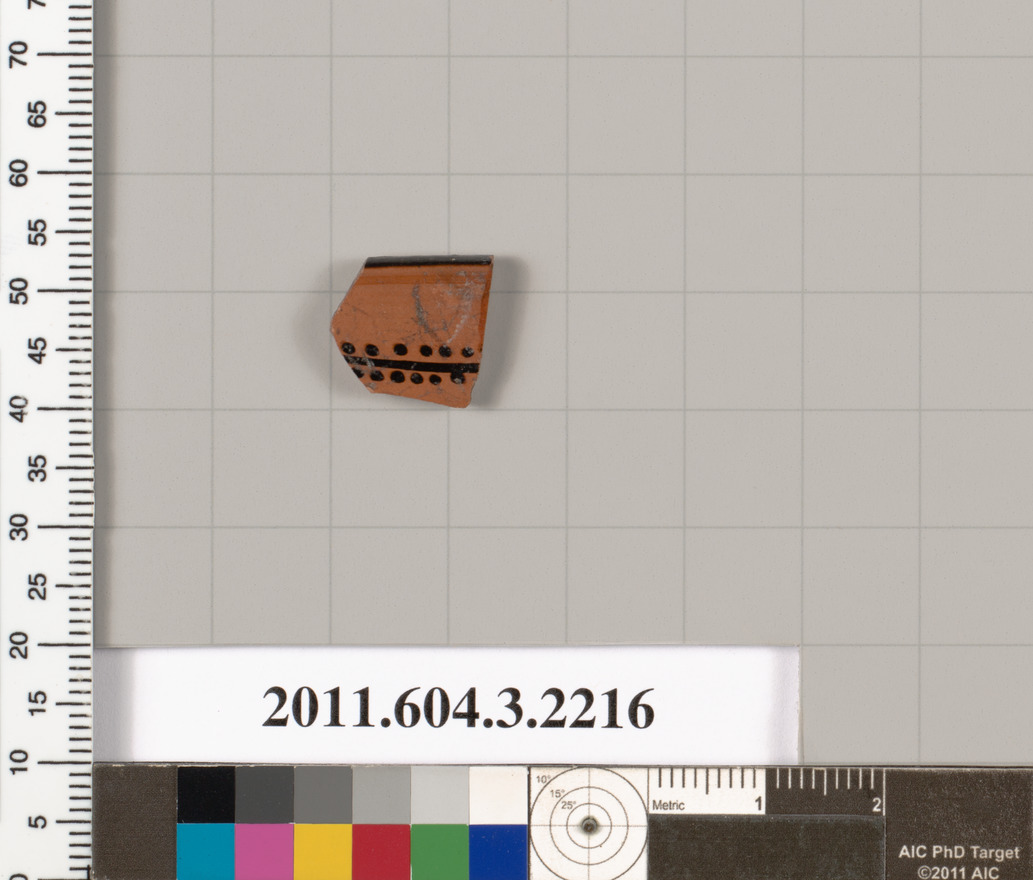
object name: kylix fragment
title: Terracotta rim fragment of a kylix (drinking cup)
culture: greek, attic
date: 525-501 BCE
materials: terracotta